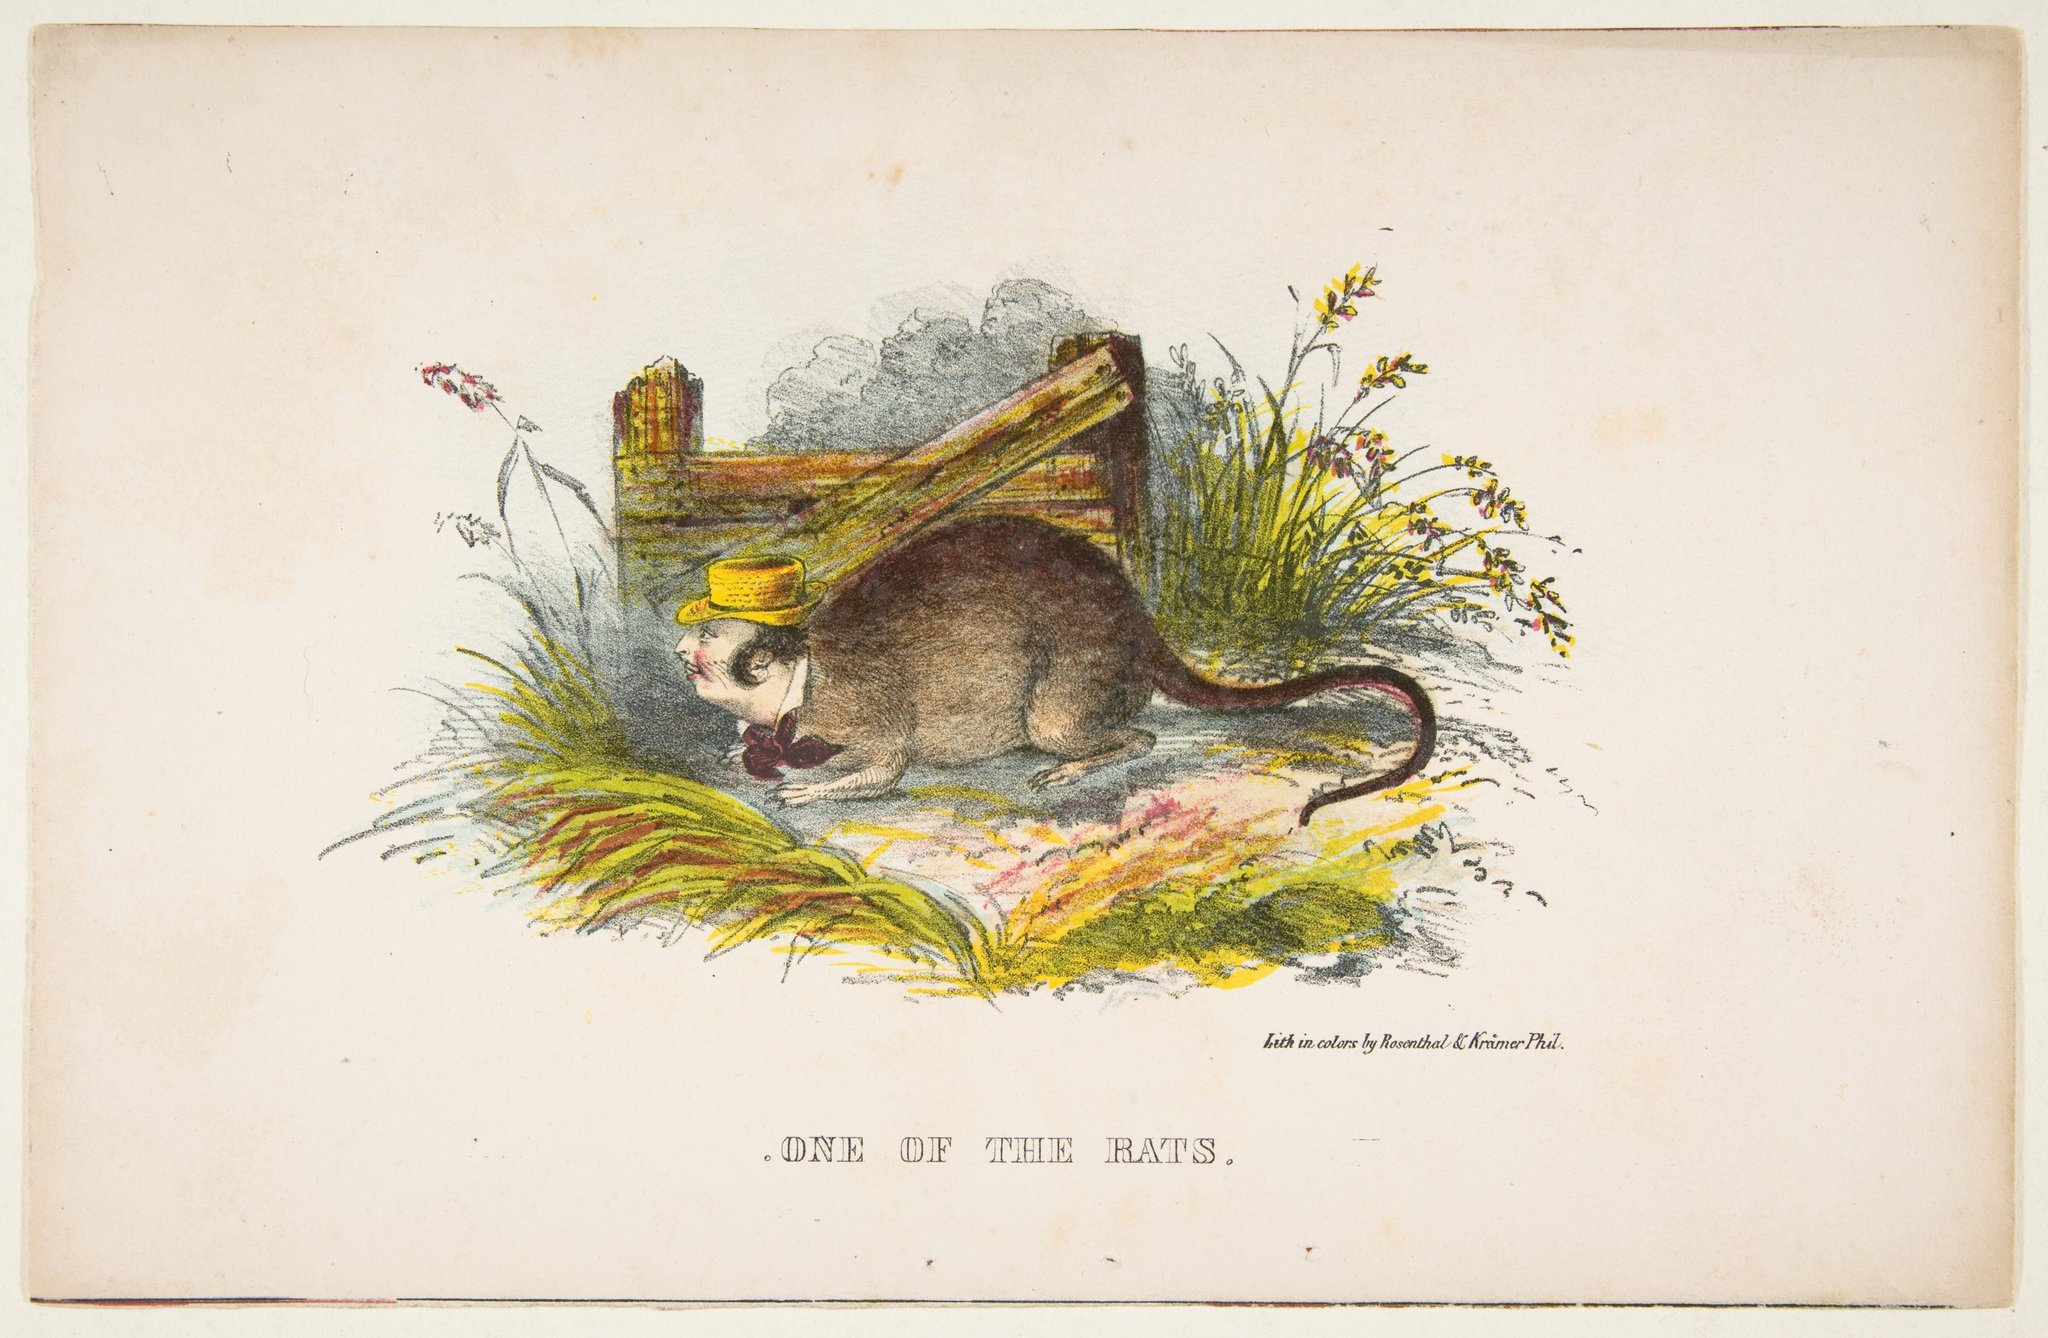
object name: print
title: One of the Rats, from "The Comic Natural History of the Human Race"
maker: henry louis stephens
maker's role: artist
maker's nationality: american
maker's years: 1824-1882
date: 1851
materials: watercolor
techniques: lithograph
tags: animals